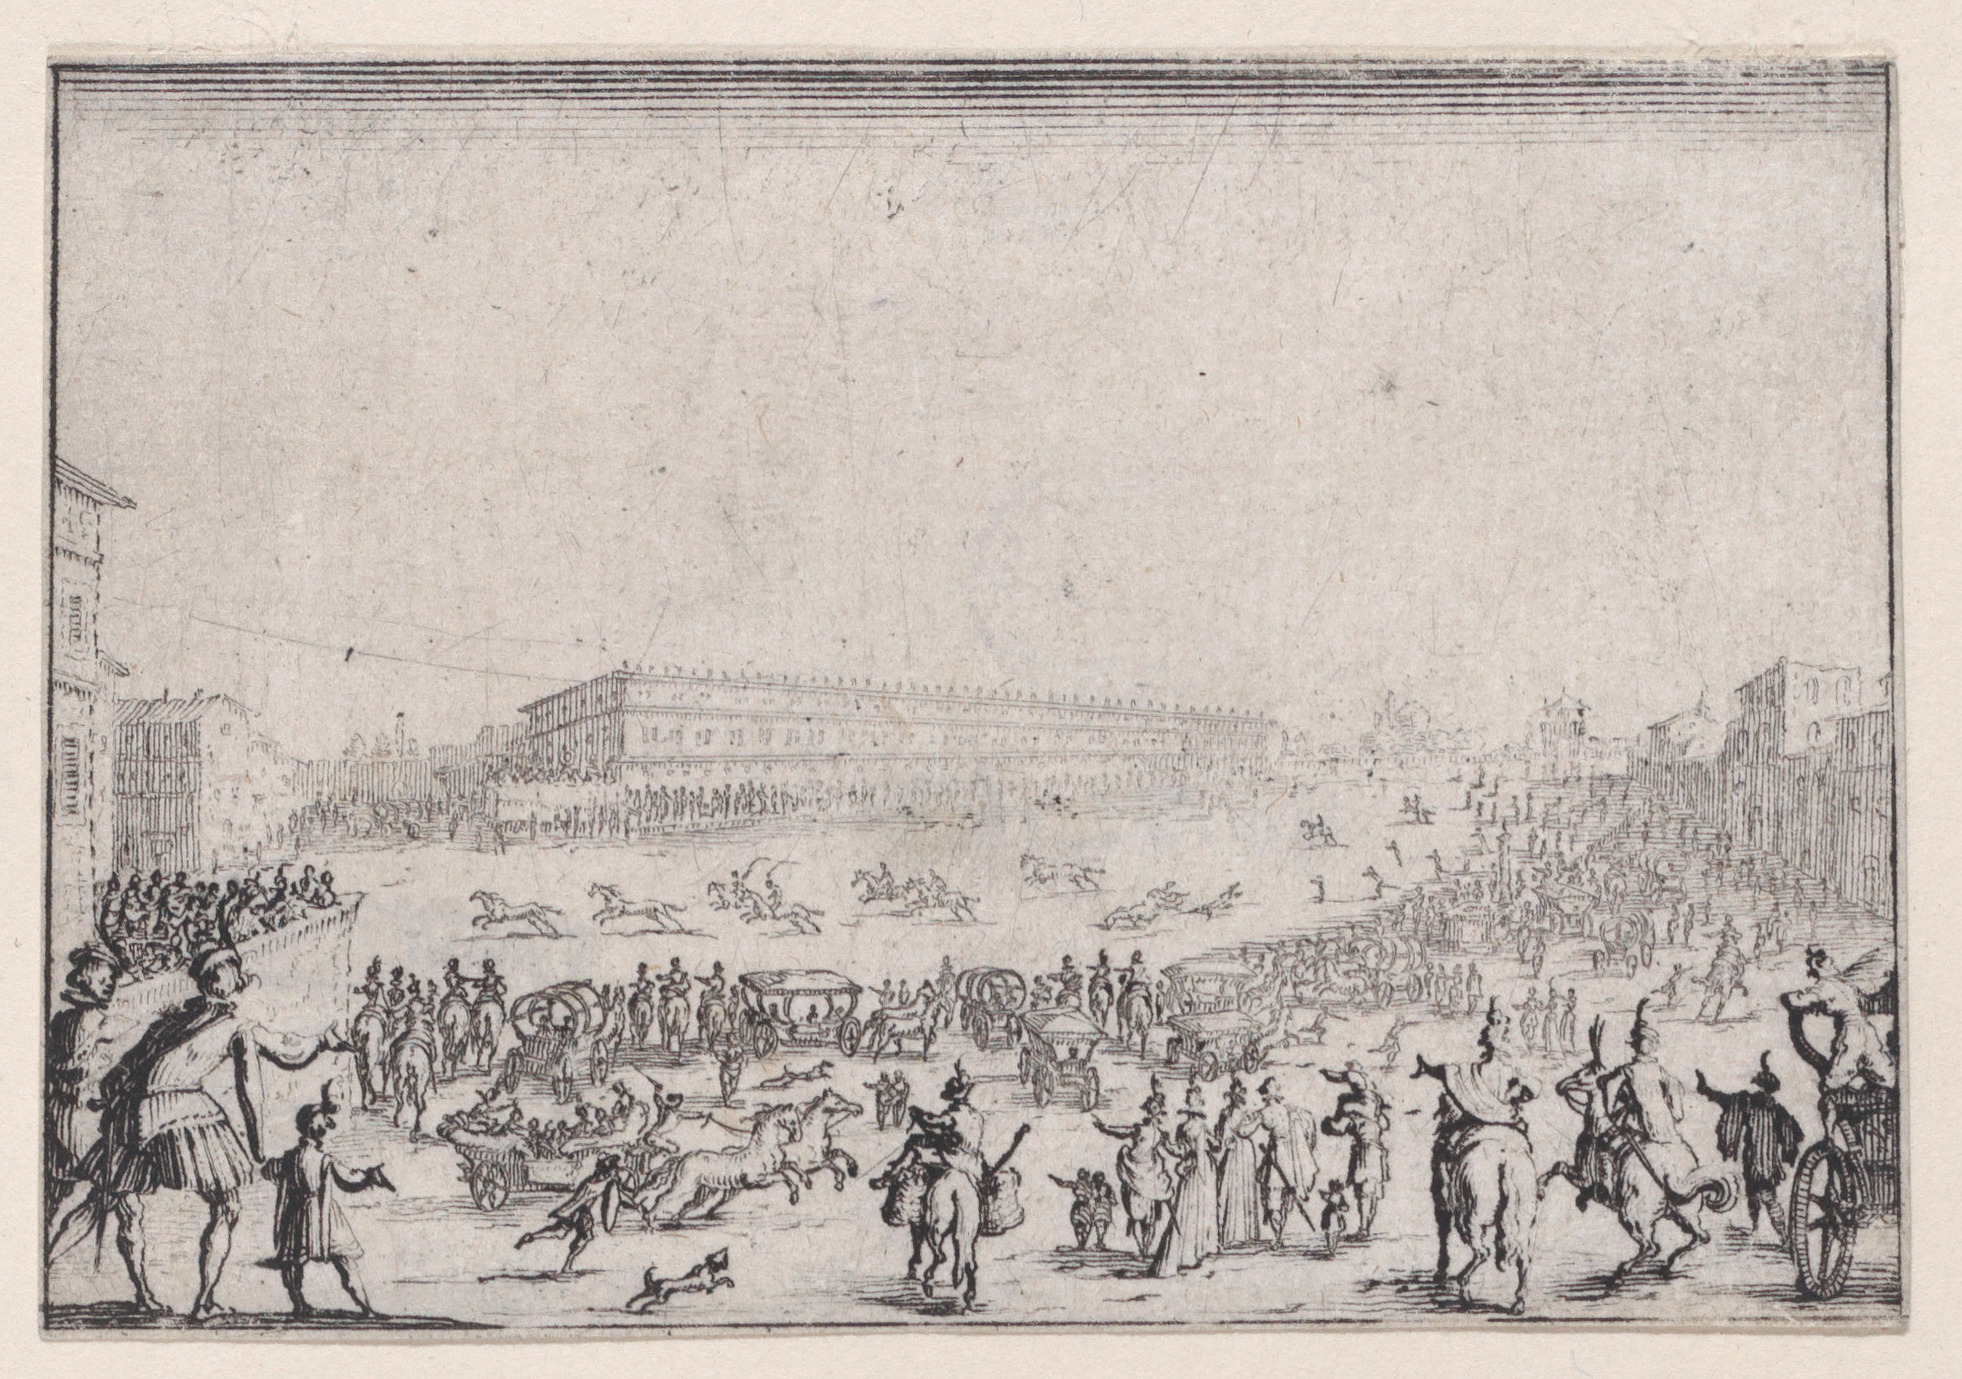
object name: print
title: La Course de Chevaux sur la Place Pitti a Florence (The Horse Race on the Piazza Pitti in Florence), from "Les Caprices" Series A, The Florence Set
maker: jacques callot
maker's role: artist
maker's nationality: french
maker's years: 1592-1635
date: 1617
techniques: etching